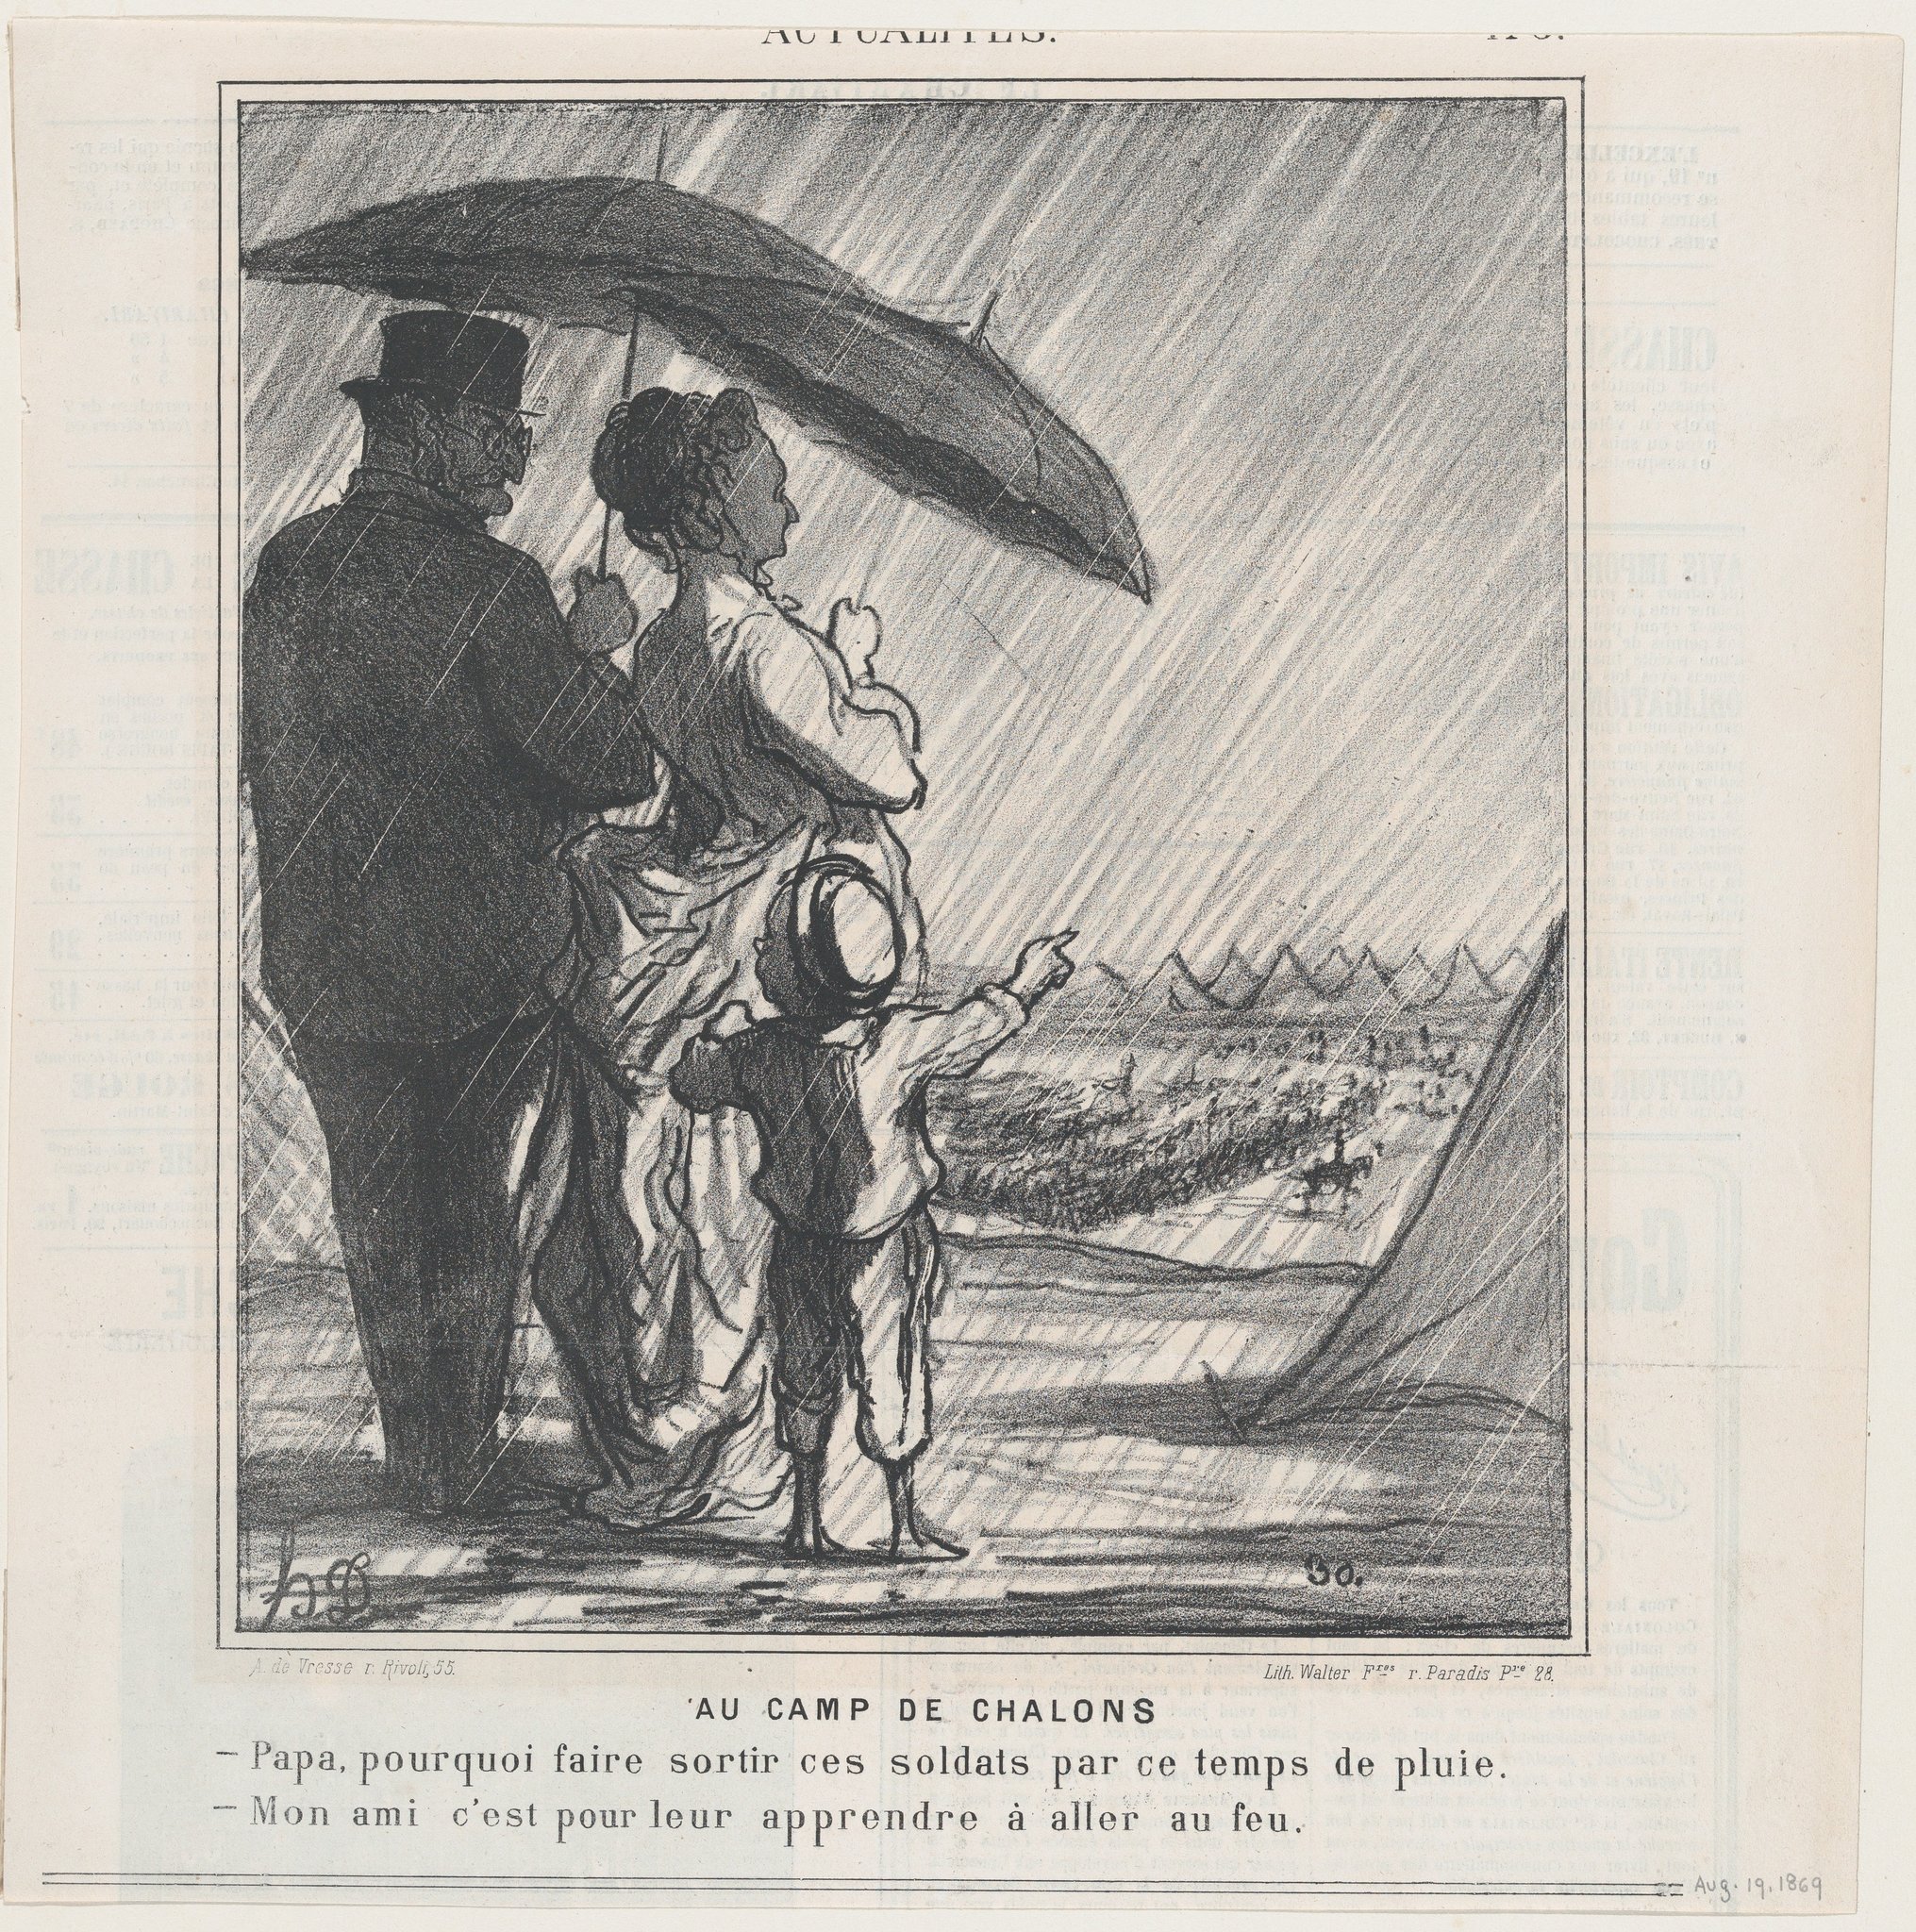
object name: print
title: At the Chalons Camp: –Papa, why do they make the soldiers go out in the rain? –My boy, it is in order for them to learn to be under fire! from 'News of the day,' published in Le Charivari, August 19, 1869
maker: honoré daumier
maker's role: artist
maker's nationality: french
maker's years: 1808-1879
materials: paper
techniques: lithograph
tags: boys,fathers,mothers,rain